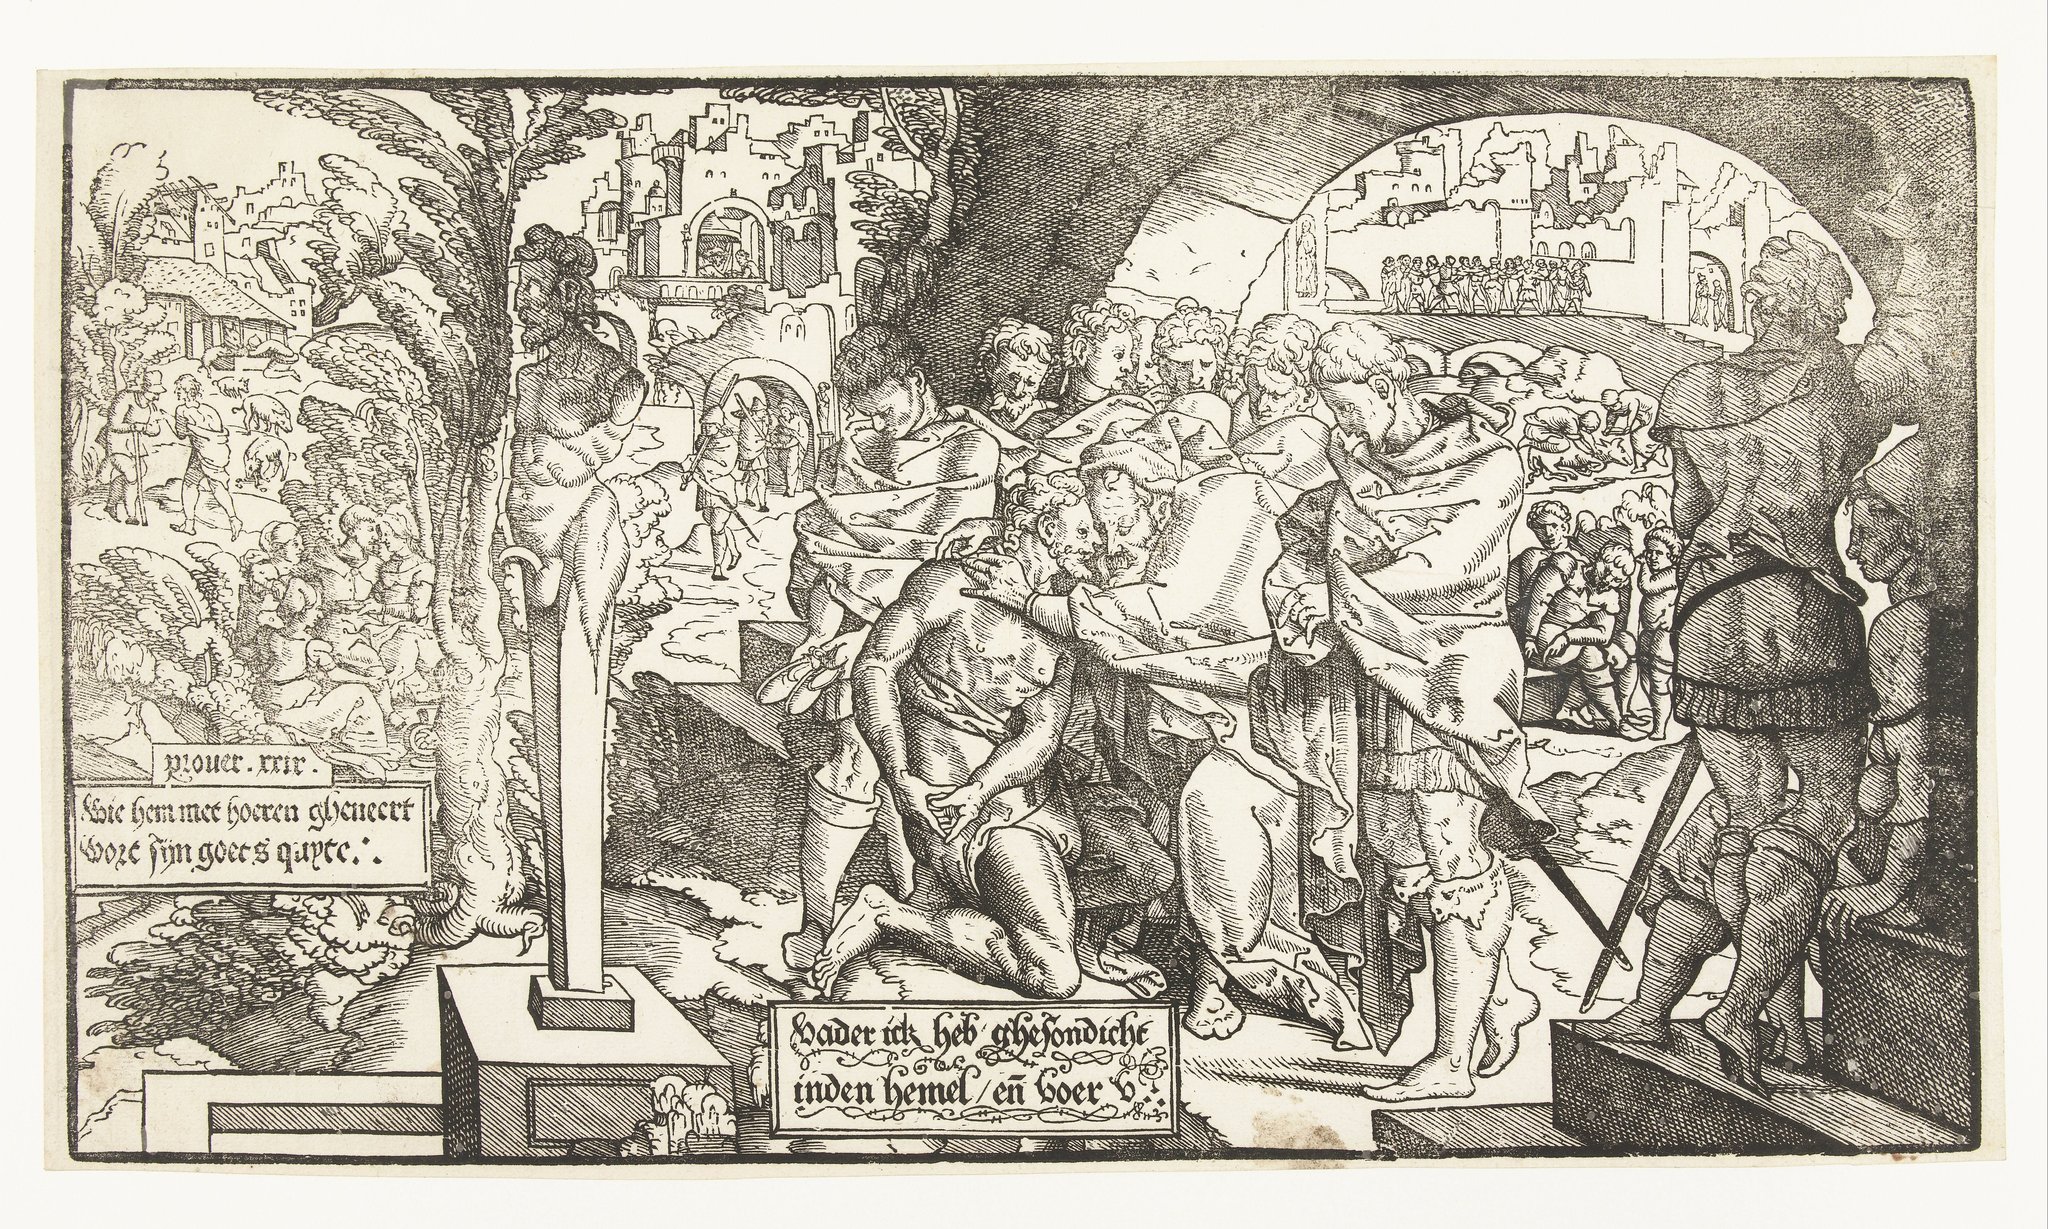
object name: print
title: De terugkeer van de verloren zoon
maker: jan van scorel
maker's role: draughtsman, painter, print maker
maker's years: 1495-1562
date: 1540-1560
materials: paper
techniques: woodcut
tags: the parable of the prodigal son (luke 15:11-32)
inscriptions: collector's mark: Lugt 240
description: Aantal scènes uit het verhaal van de verloren zoon in één voorstelling. In het midden de terugkeer van de verloren zoon, zijn vader omhelst hem. twee cartouches met tekst.